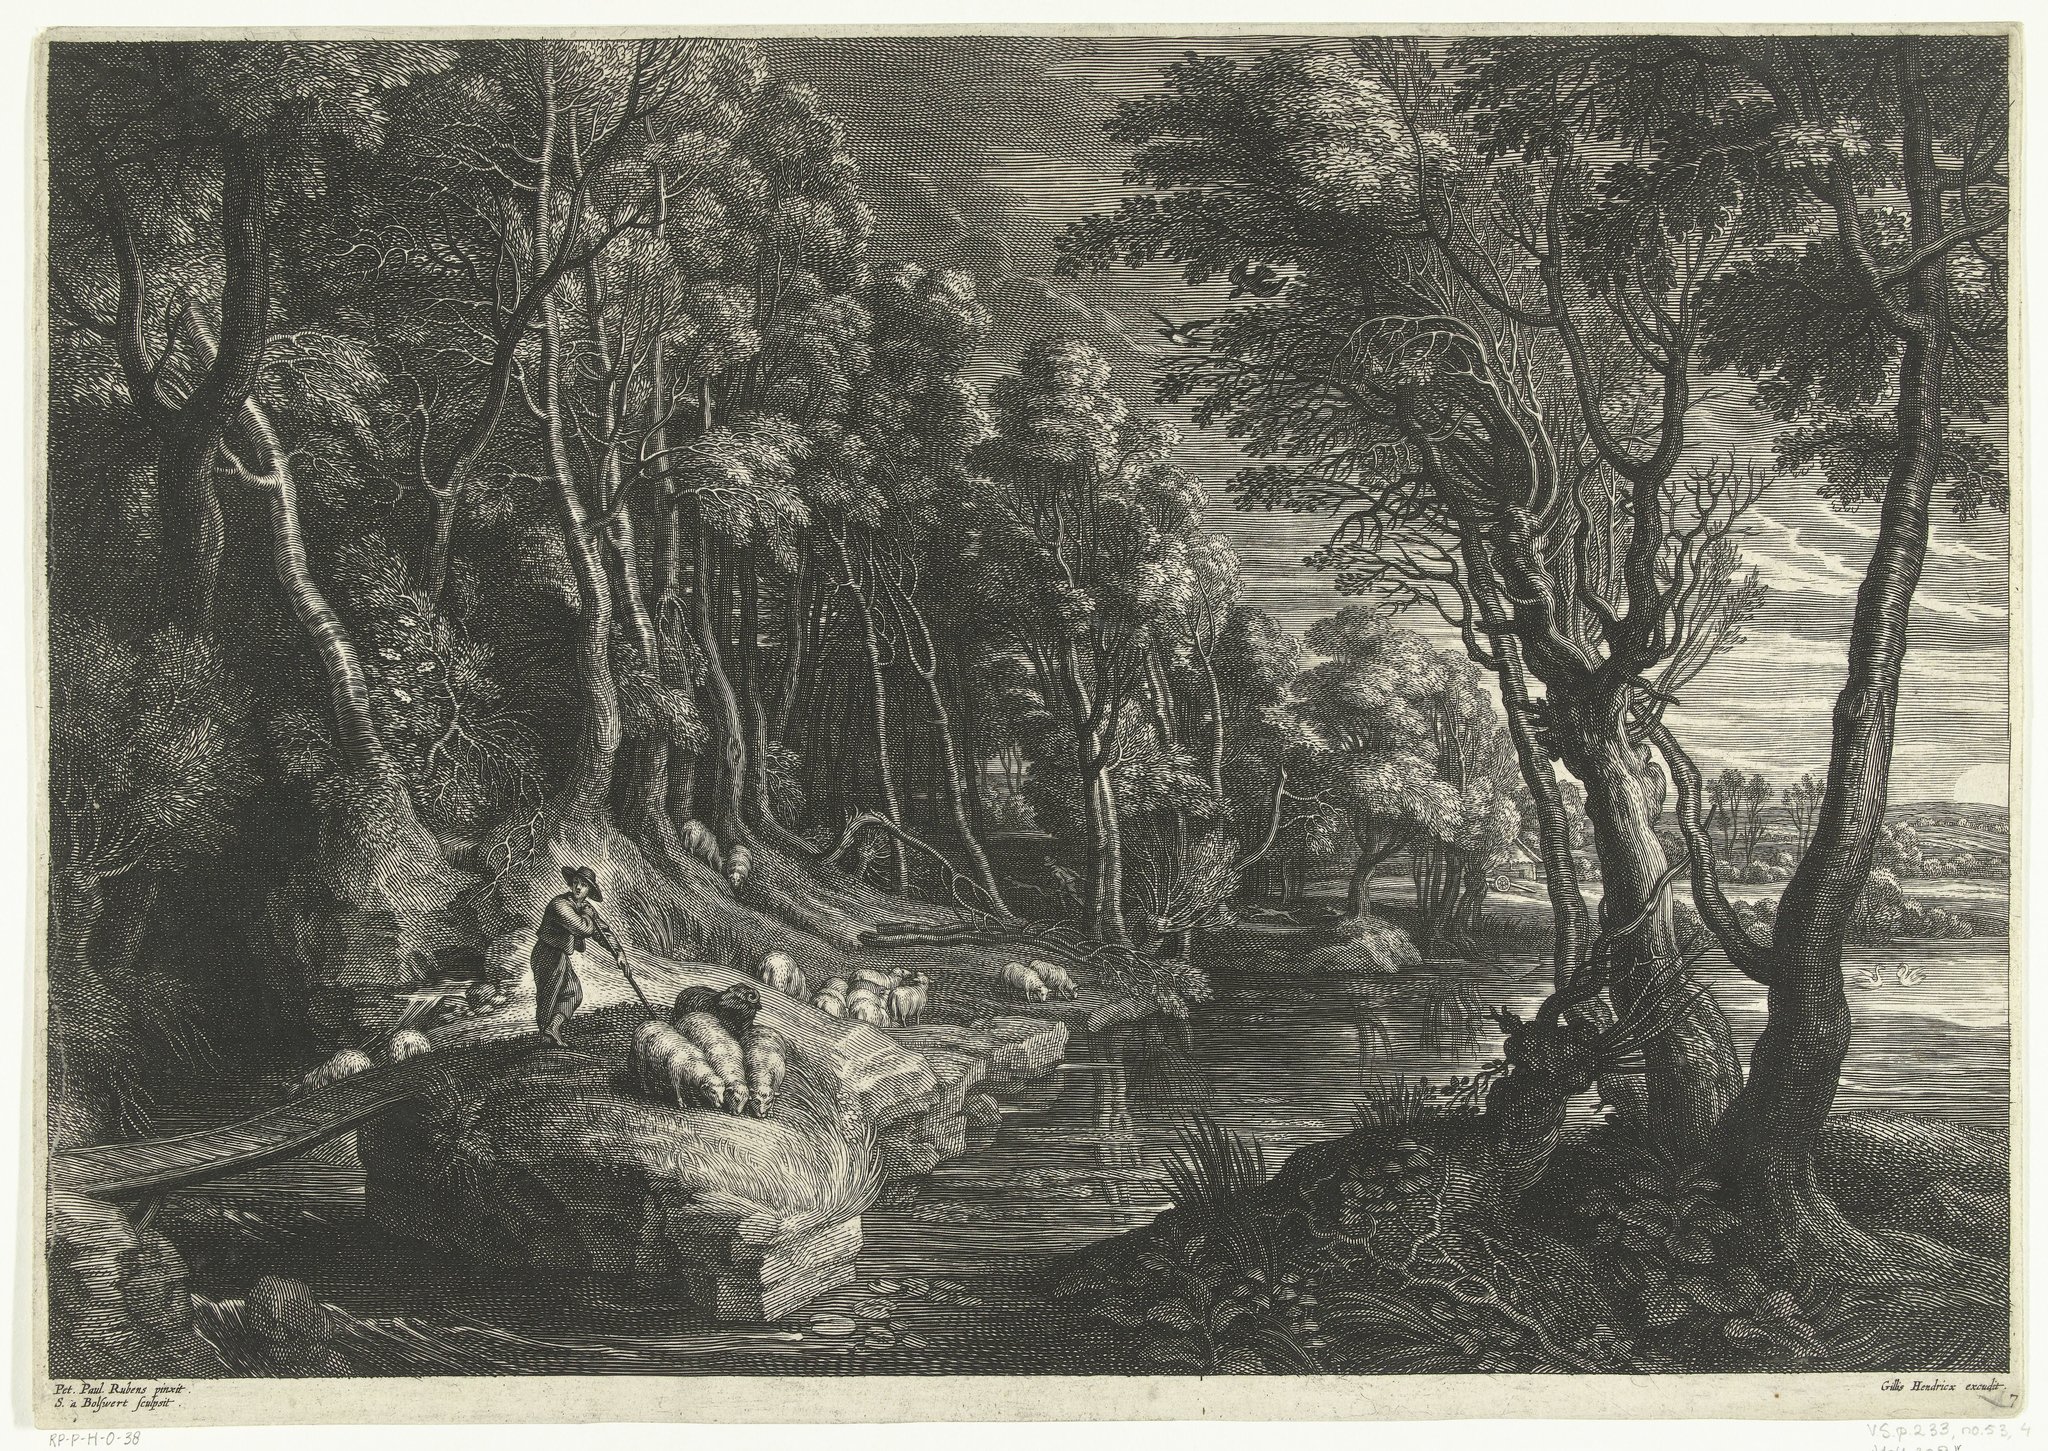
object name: print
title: Landschap met herder en kudde schapen bij water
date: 1596-1659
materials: paper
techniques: engraving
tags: herding, herdsman, herdswoman, shepherd, shepherdess, cowherd, etc., brook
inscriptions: collector's mark: Lugt 10, collector's mark: Lugt 11, inscription: ‘B 29 - 39.58’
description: Prent naar schilderij van Peter Paul Rubens.